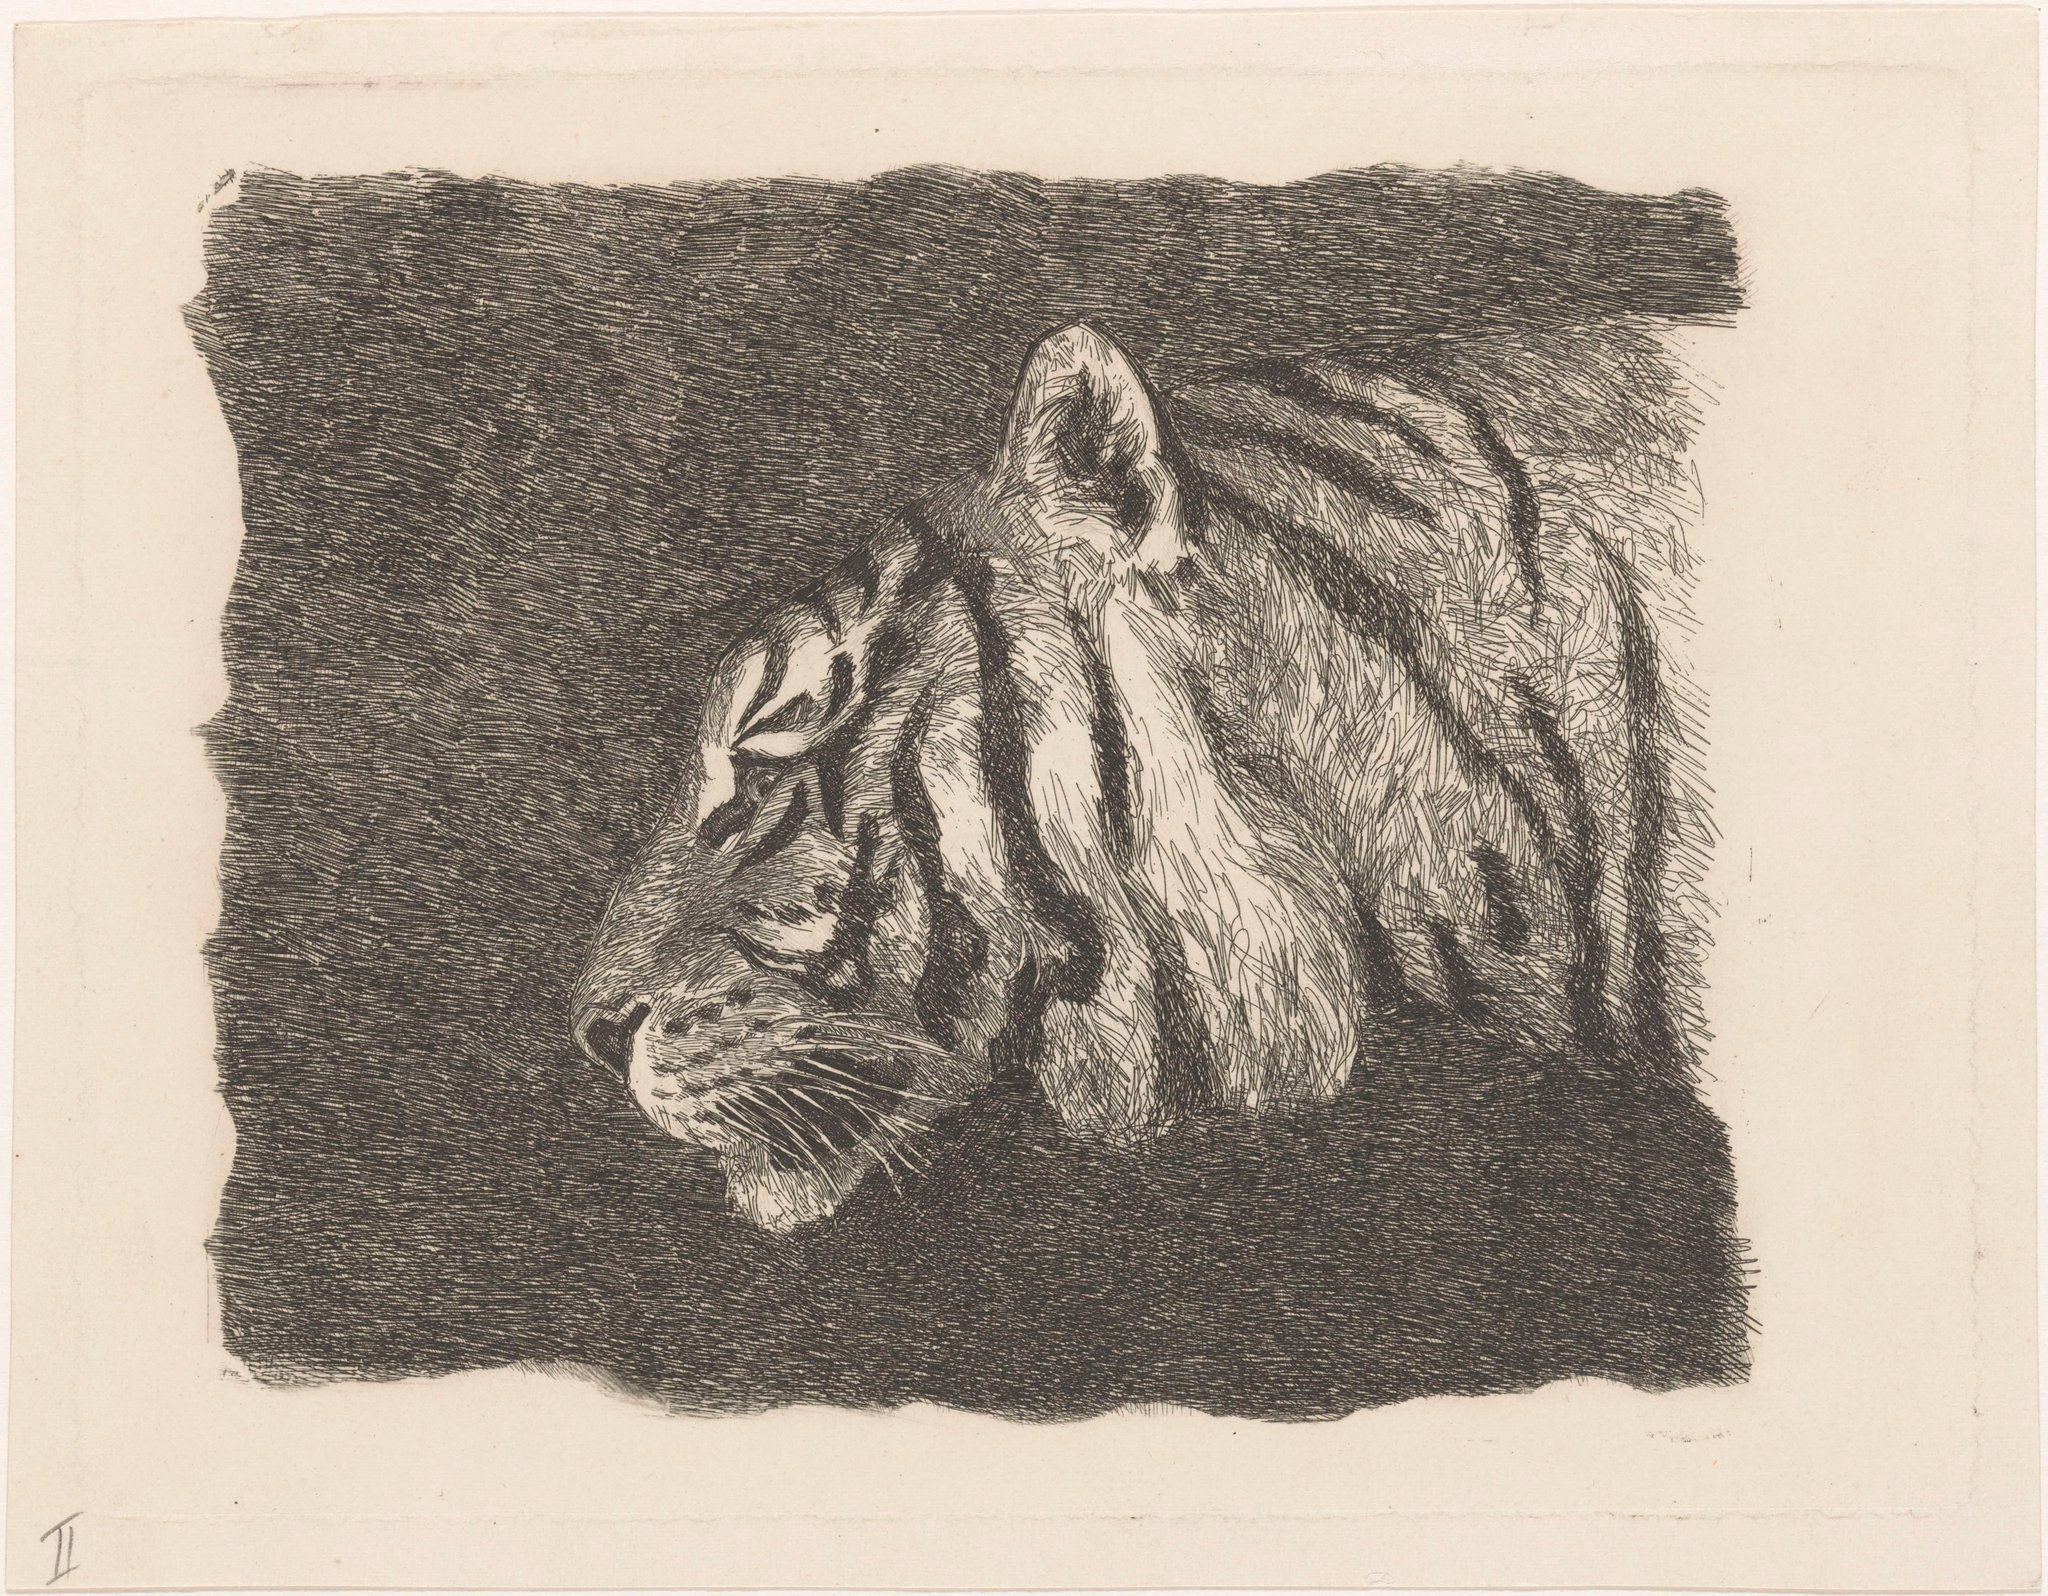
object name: print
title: Tijgerkop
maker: august le gras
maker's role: draughtsman, print maker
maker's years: 1864-1915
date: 1874-1886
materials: paper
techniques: etching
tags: beasts of prey, predatory animals: tiger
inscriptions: collector's mark: Lugt 2228